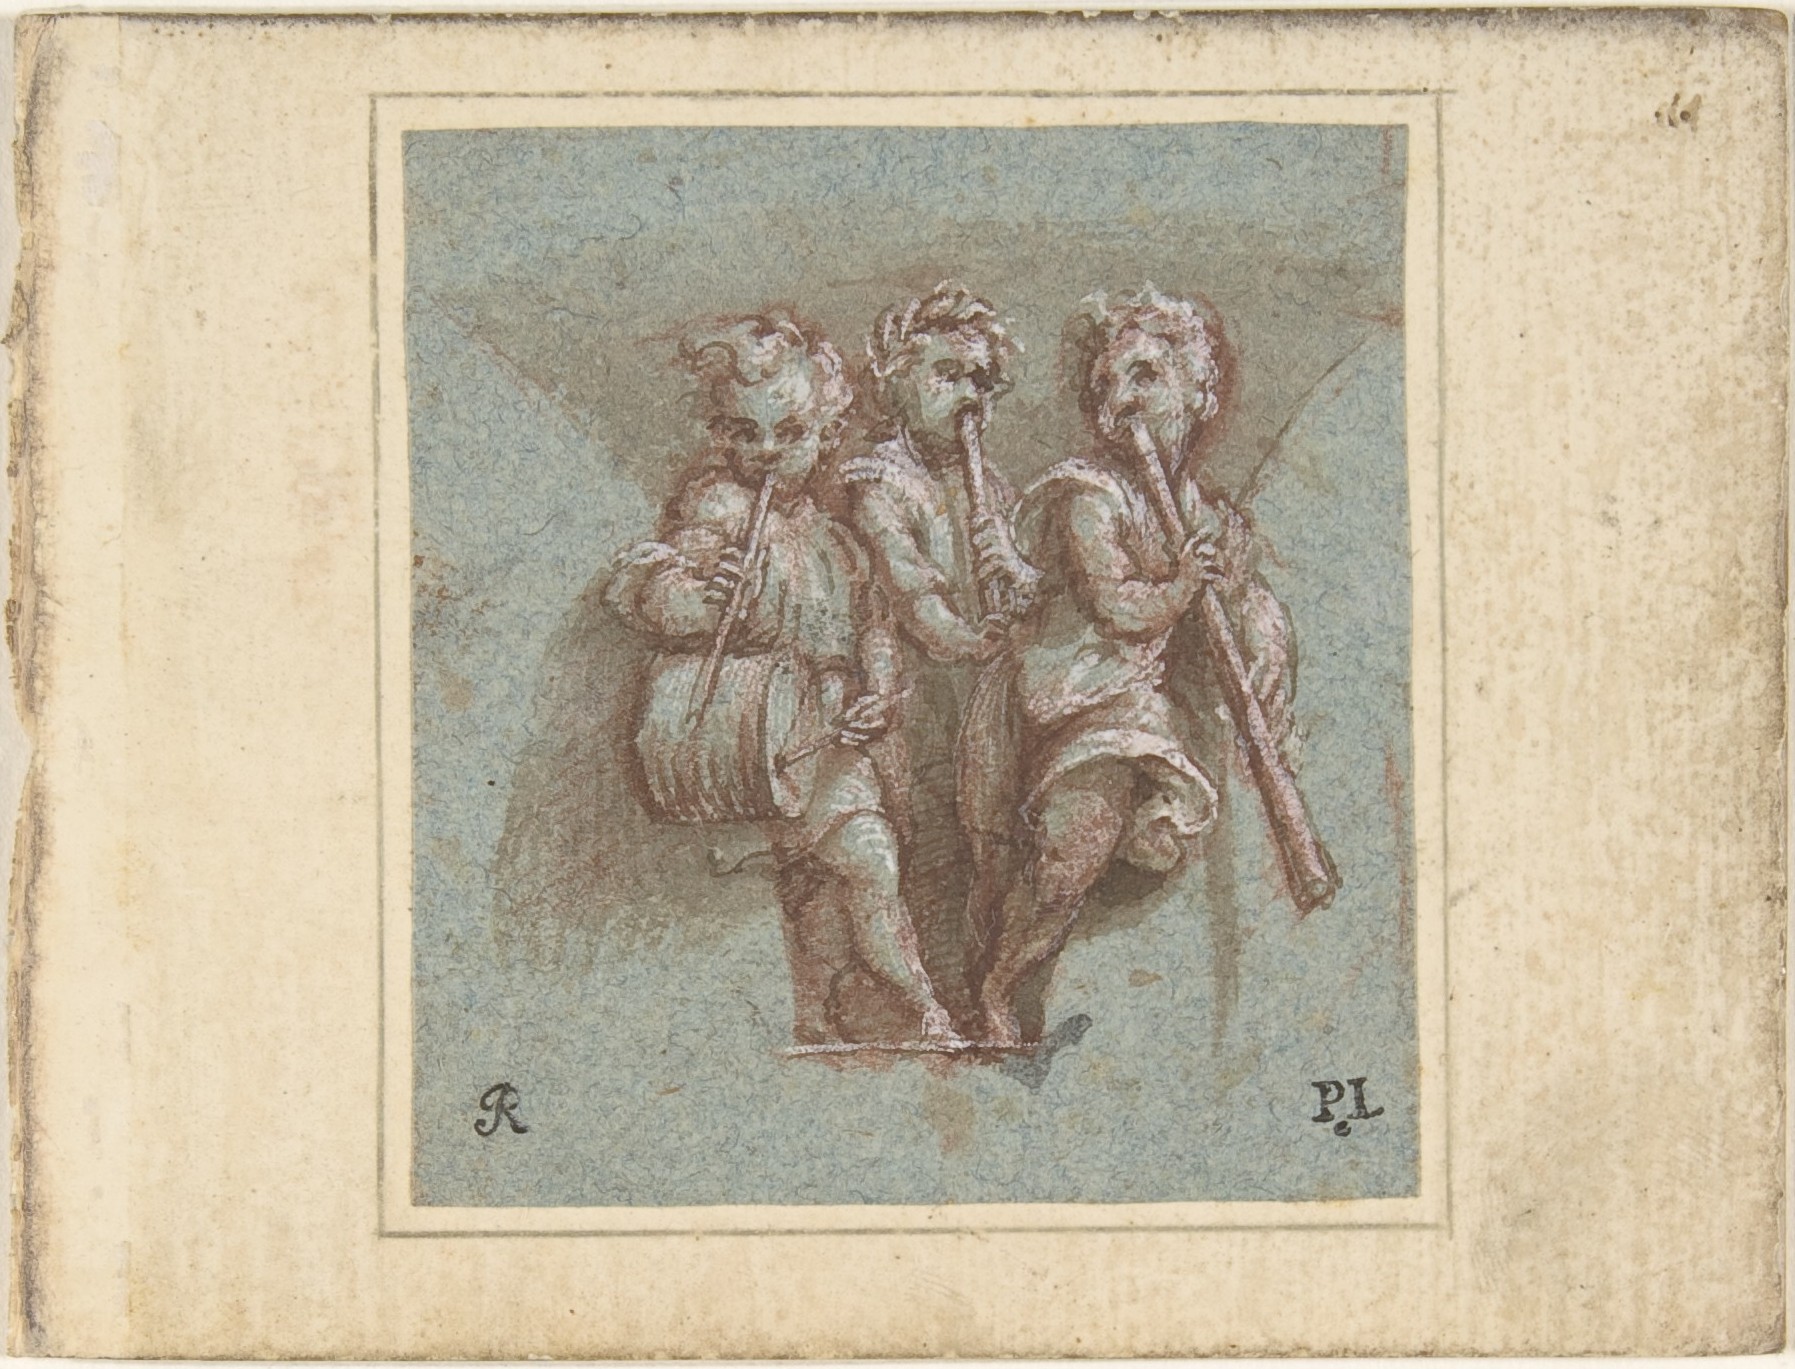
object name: drawing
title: Design for a Pendentive: Youthful Musicians with Wind Instruments and a Drum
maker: pomponio amalteo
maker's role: artist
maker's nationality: italian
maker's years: 1505-1588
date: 1505-1588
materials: chalk, ink, paper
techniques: brush, highlighting, pen, wash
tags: musical instruments,children,drums,musicians